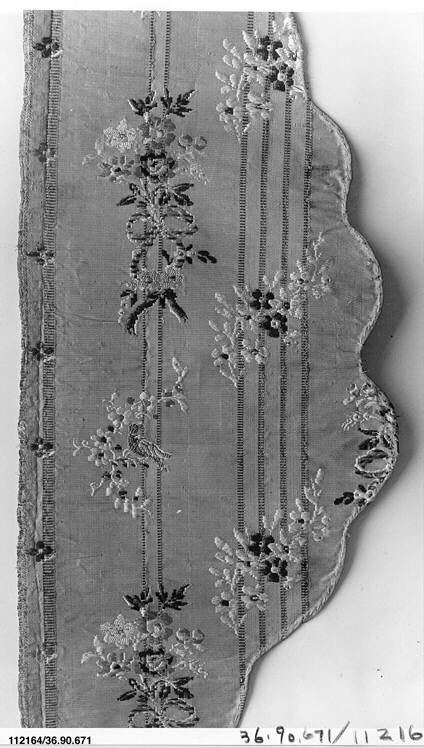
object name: piece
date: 1701-1800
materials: silk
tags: flowers